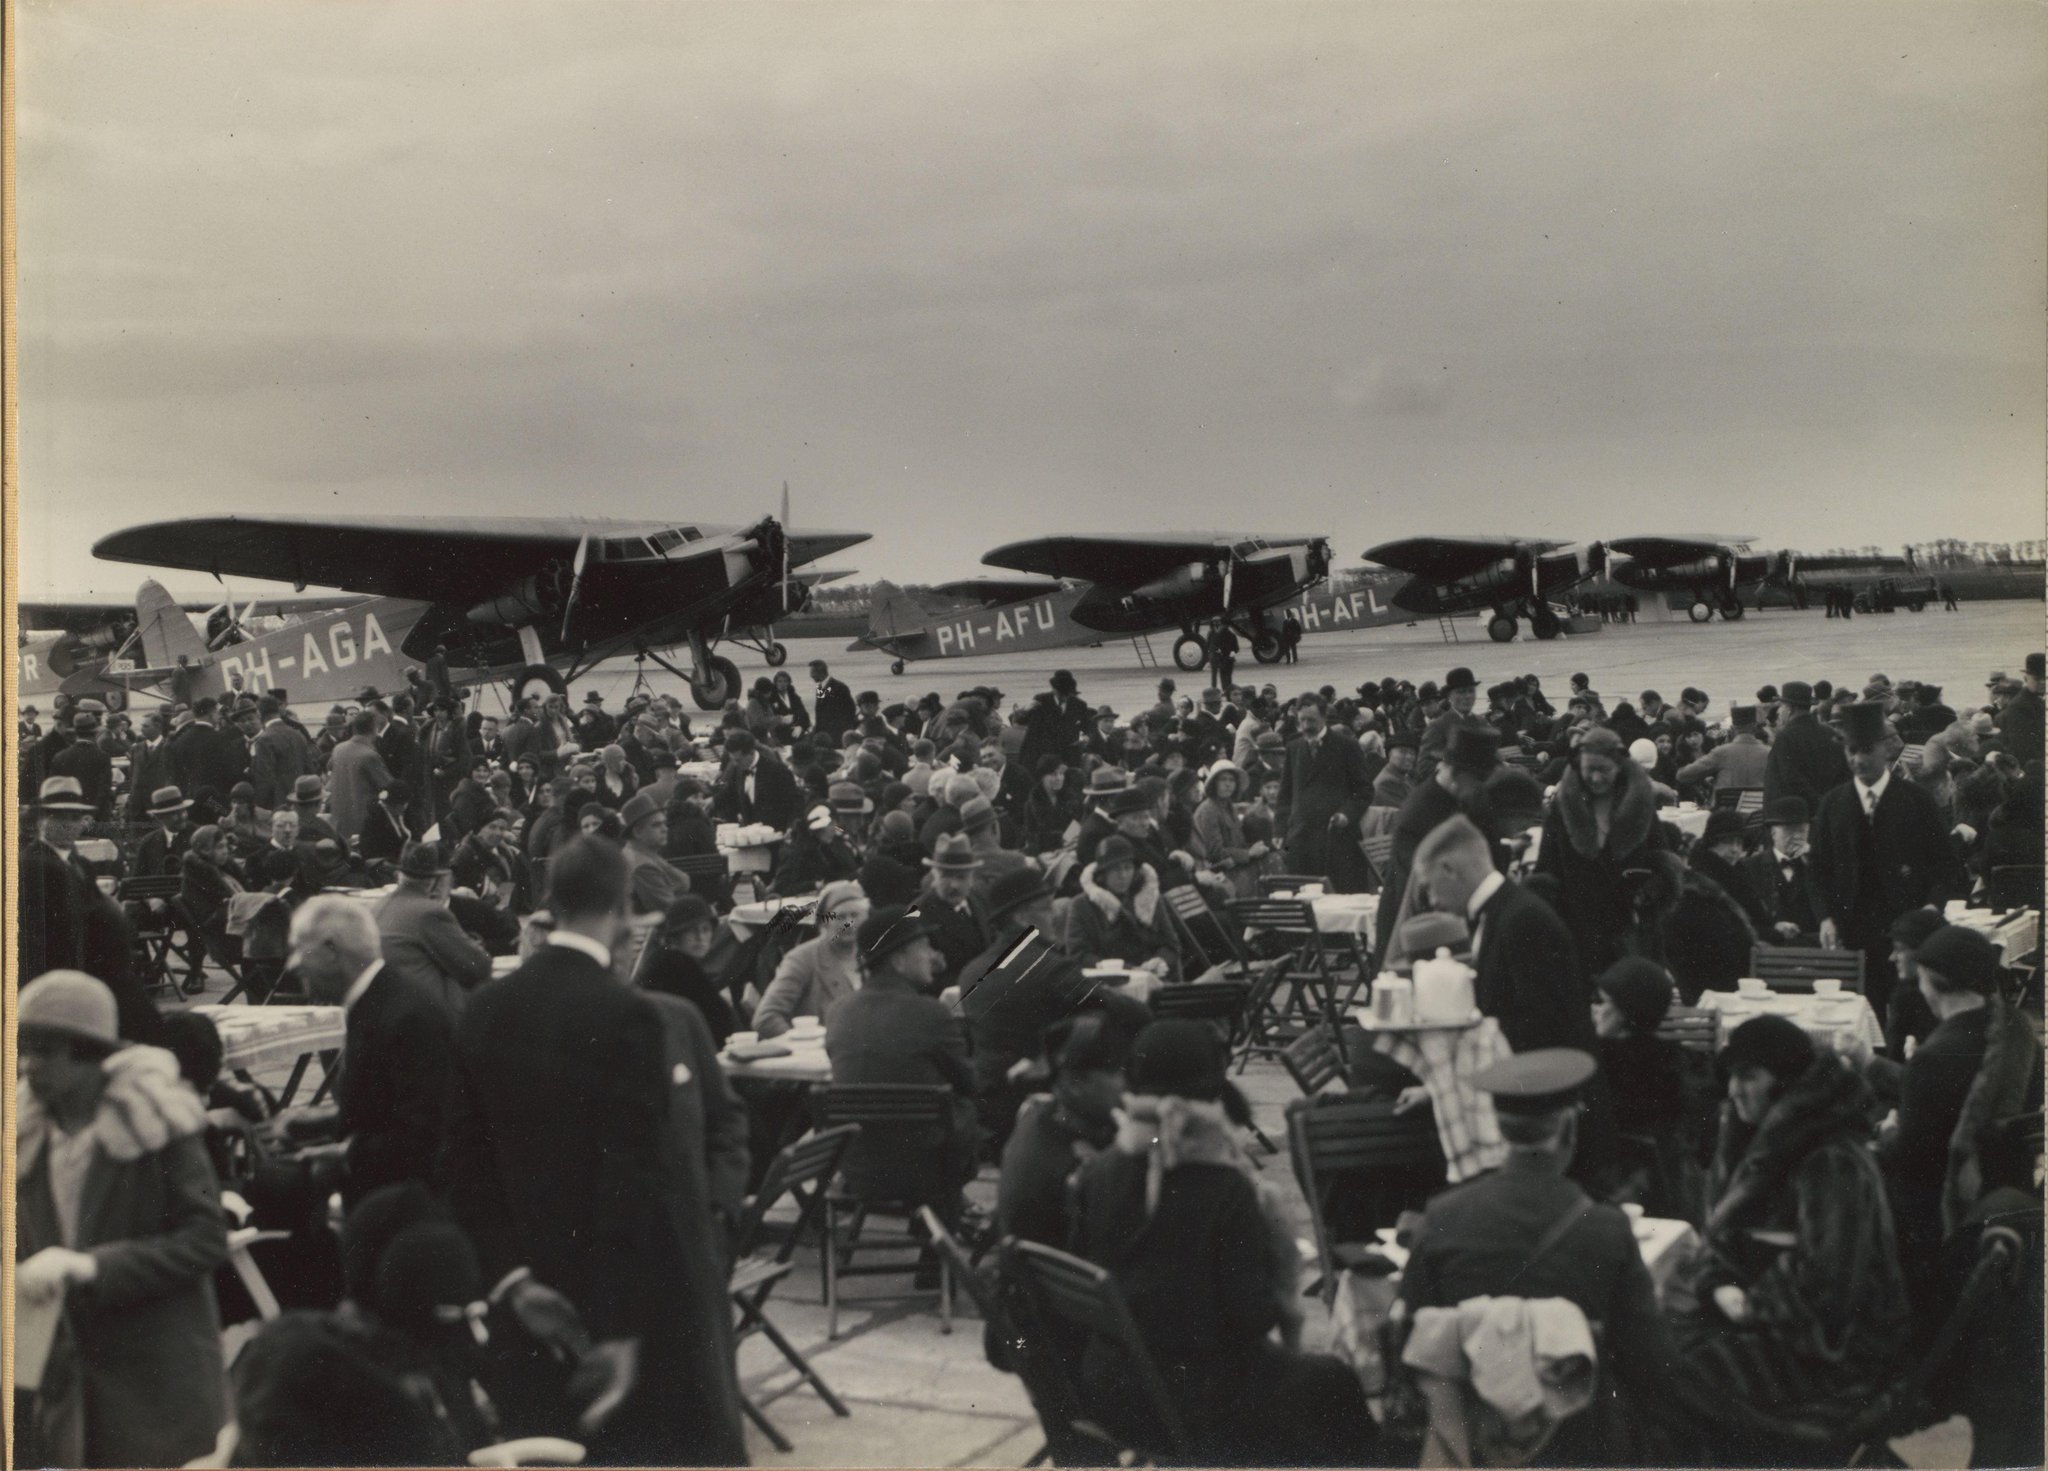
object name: album leaf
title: Luchtvaartevenement, vermoedelijk Schiphol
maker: Anonymous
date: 1925-1935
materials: cardboard, paper, photographic support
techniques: gelatin silver print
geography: schiphol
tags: airborne traffic, aviation, airfield, airport, travelling; tourism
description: Albumblad met een foto van mensen zittend aan tafels op een vliegveld met op de achtergrond vier geparkeerde vliegtuigen. Onderdeel van Herdenkingsalbum van de Indië-lijn van de KLM, deel I.